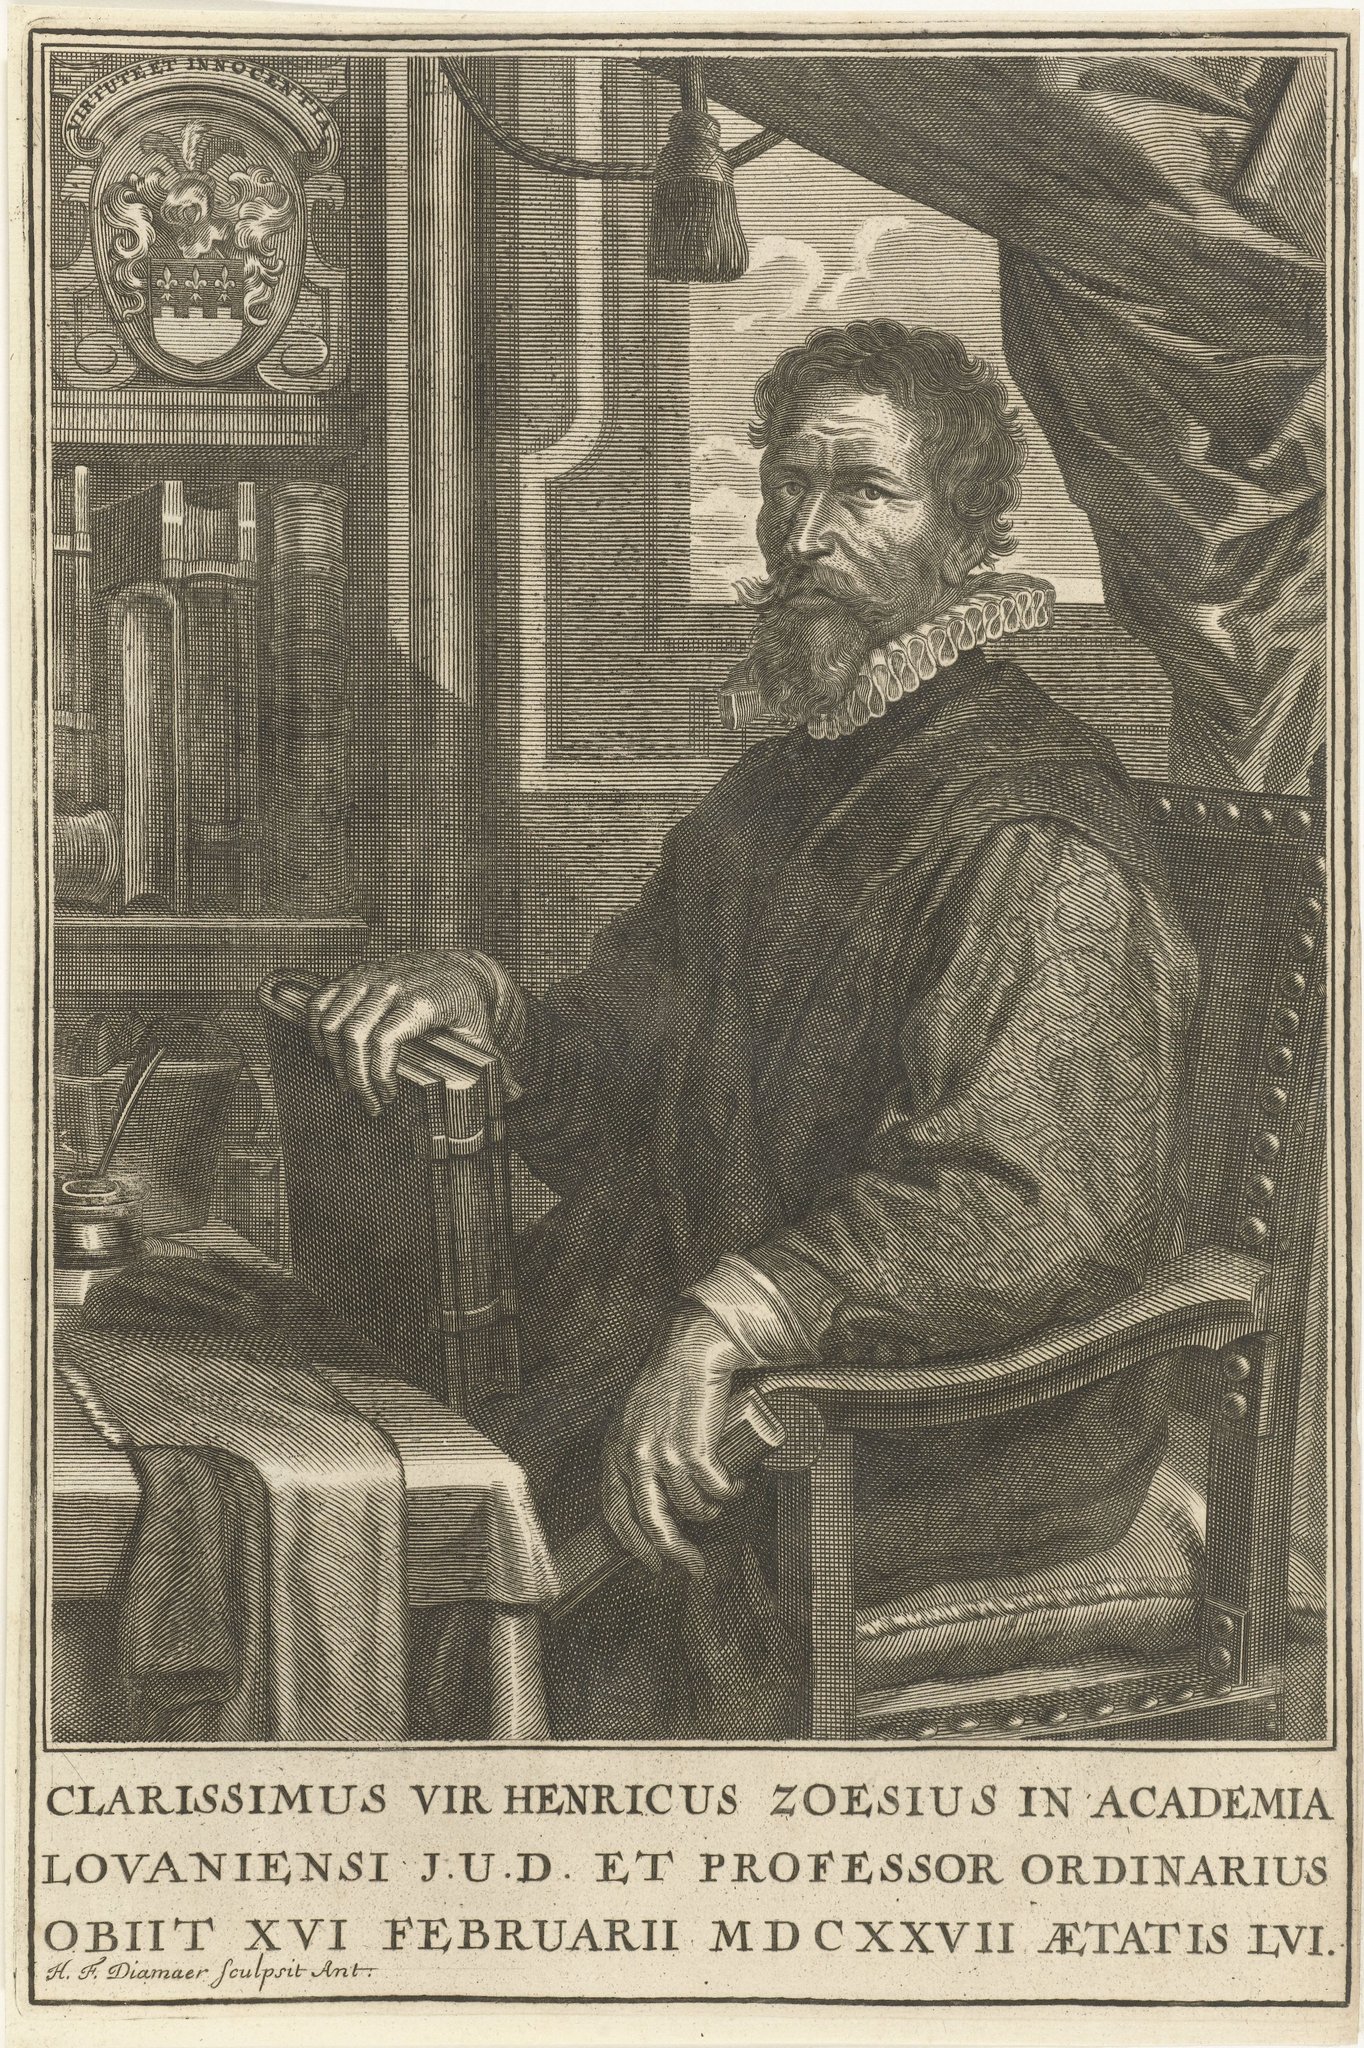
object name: print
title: Portret van Hendrik Zoesius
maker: hendrik frans volkert diamaer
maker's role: print maker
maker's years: 1685-1726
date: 1695-1726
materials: paper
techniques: engraving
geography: antwerp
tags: louvain, professor (+ teacher, professor)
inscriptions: collector's mark: Lugt 2228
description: Portret van Hendrik Zoesius, zittend met boeken bij tafel. Onder portret drie regels Latijnse tekst.